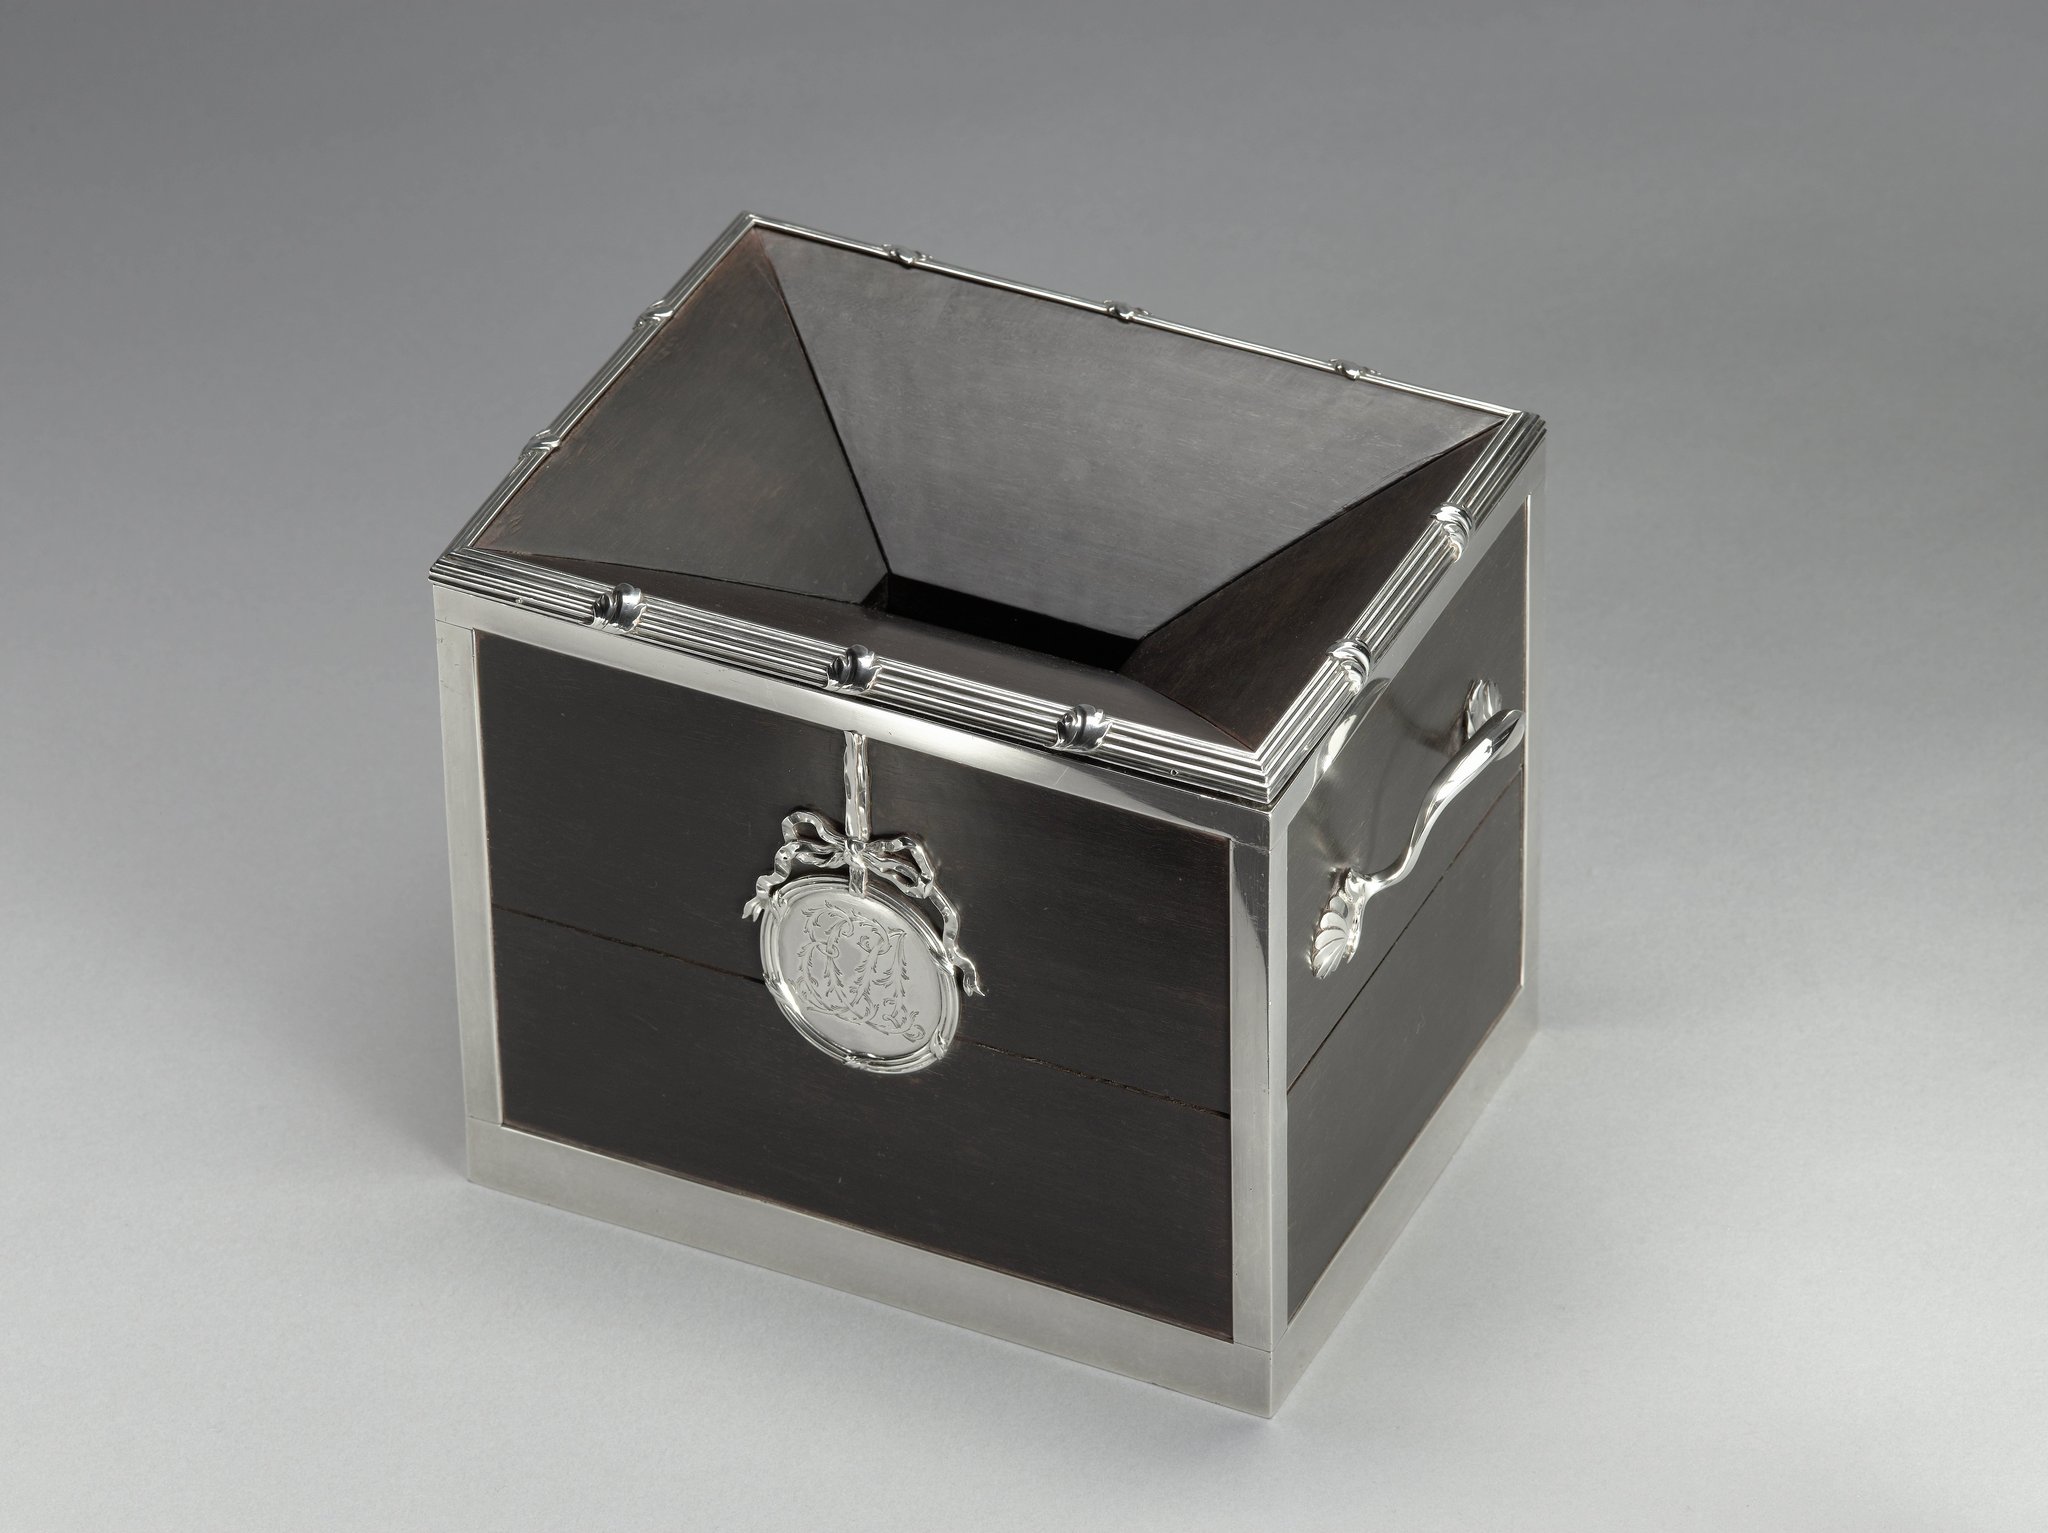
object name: offerblok, offerbus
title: Offerblok voor The English Reformed Church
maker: johannes schiotling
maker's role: silversmith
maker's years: 1730-1799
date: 1771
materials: wood, silver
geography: amsterdam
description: Baptismal font, one large and two small bread dishes and two ebony offertory boxes, made for the English Reformed Church in Amsterdam, largely at the expense of the banker John Hope. Silver and ebony. Amsterdam, 1771, by Johannes Schiotling. On loan from the English Reformed Church, Amsterdam.